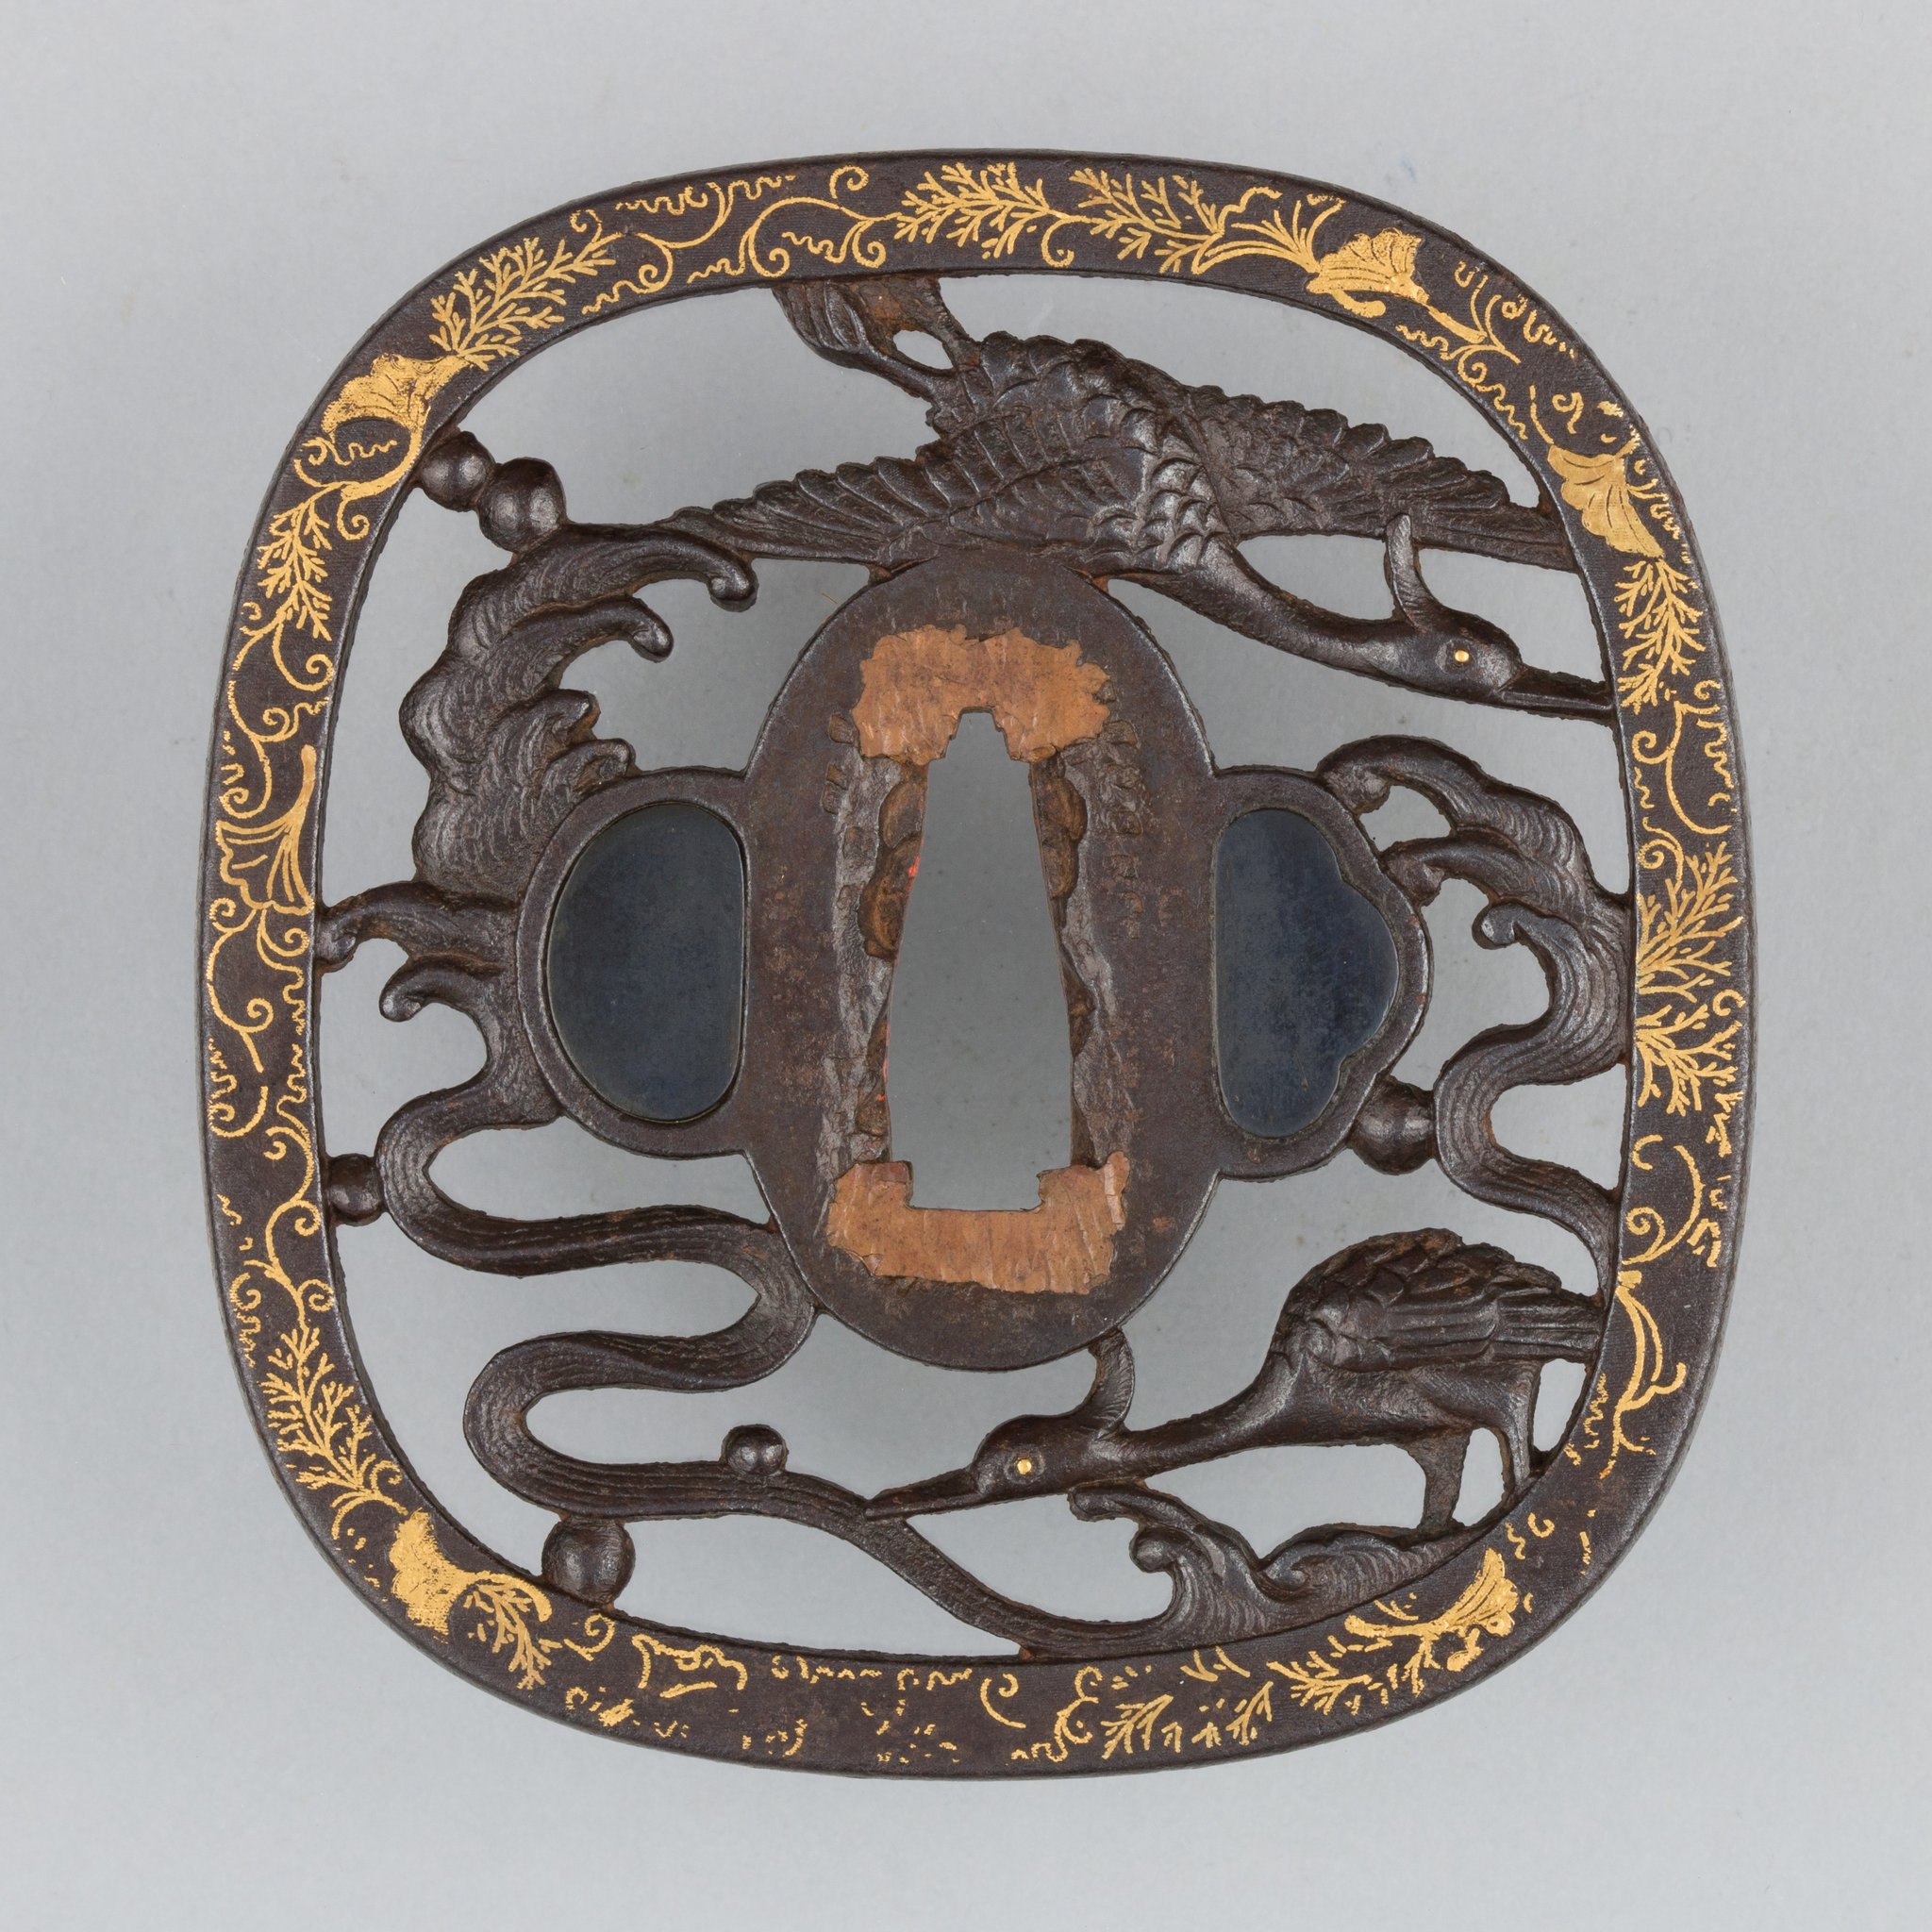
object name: sword guard tsuba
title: Sword Guard (Tsuba)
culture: japanese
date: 1601-1700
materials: copper, gold alloy, gold, iron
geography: japan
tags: birds